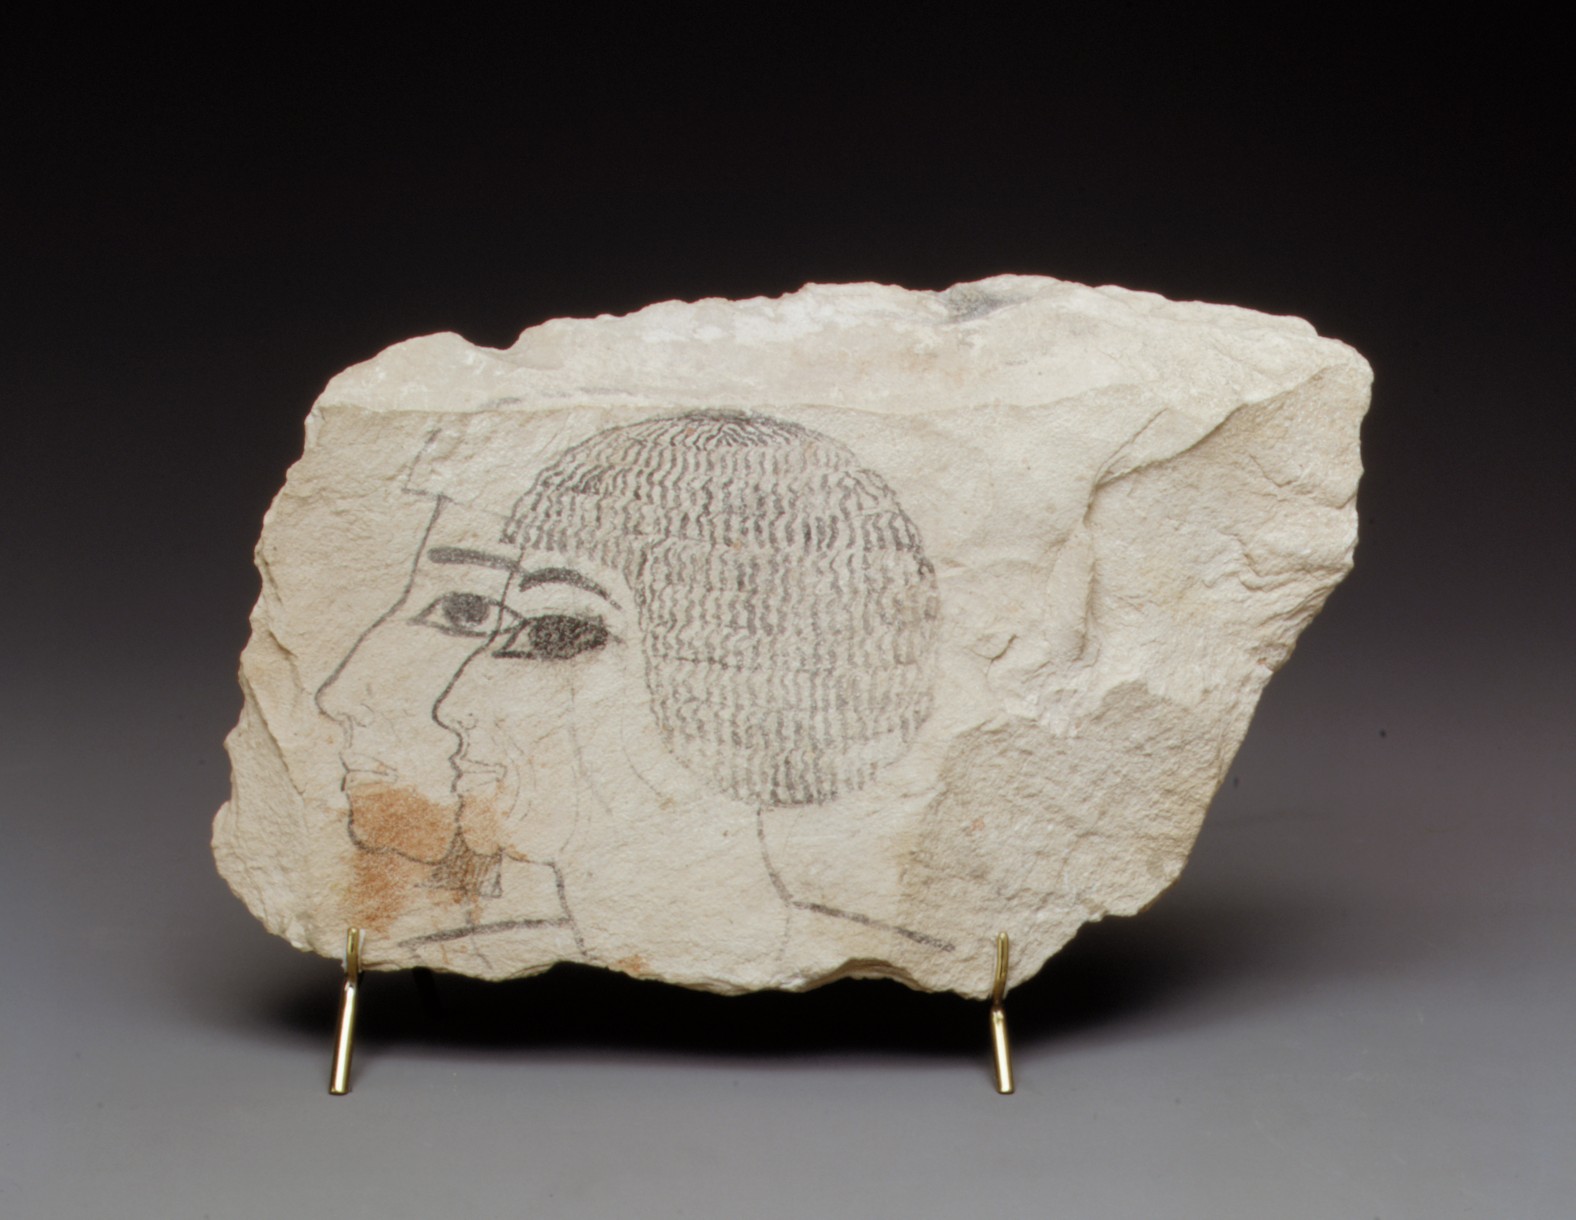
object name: ostracon, figured, senenmut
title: Artist's Sketches of Senenmut, Sketch of Small Rodent on Opposite Side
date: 1479-1458 BCE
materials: ink, limestone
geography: egypt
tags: men